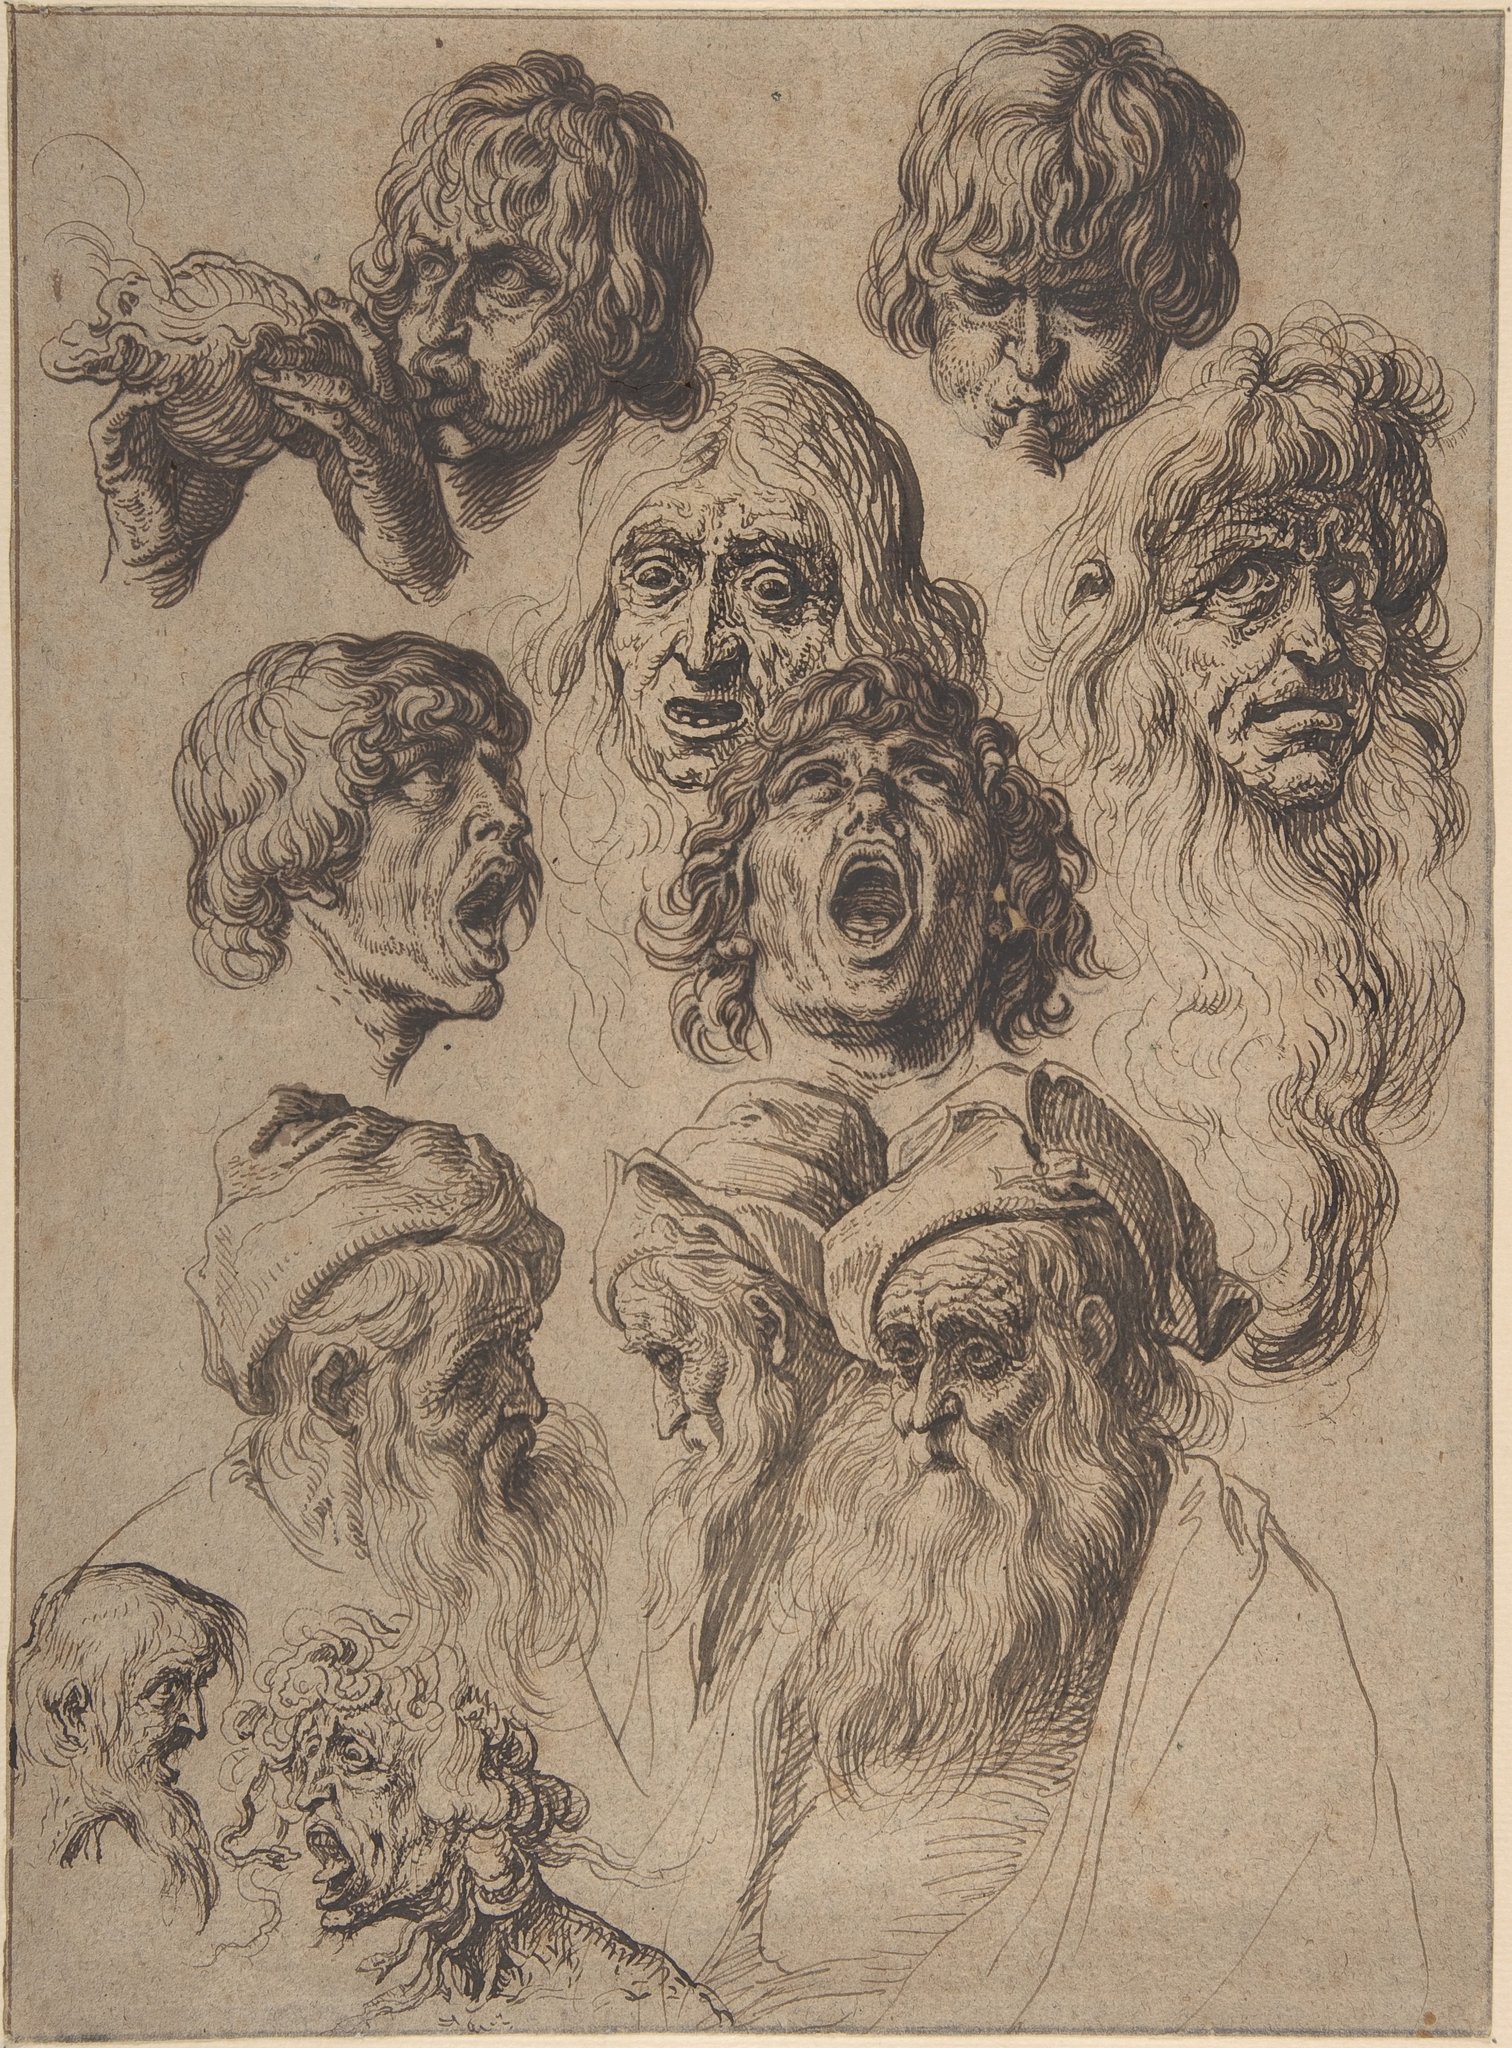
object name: drawing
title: Study of Eleven Heads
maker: jacques de gheyn (ii)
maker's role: artist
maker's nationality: netherlandish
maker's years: 1565-1629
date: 1567-1633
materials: chalk, graphite, ink, paper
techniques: pen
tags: faces,heads,men